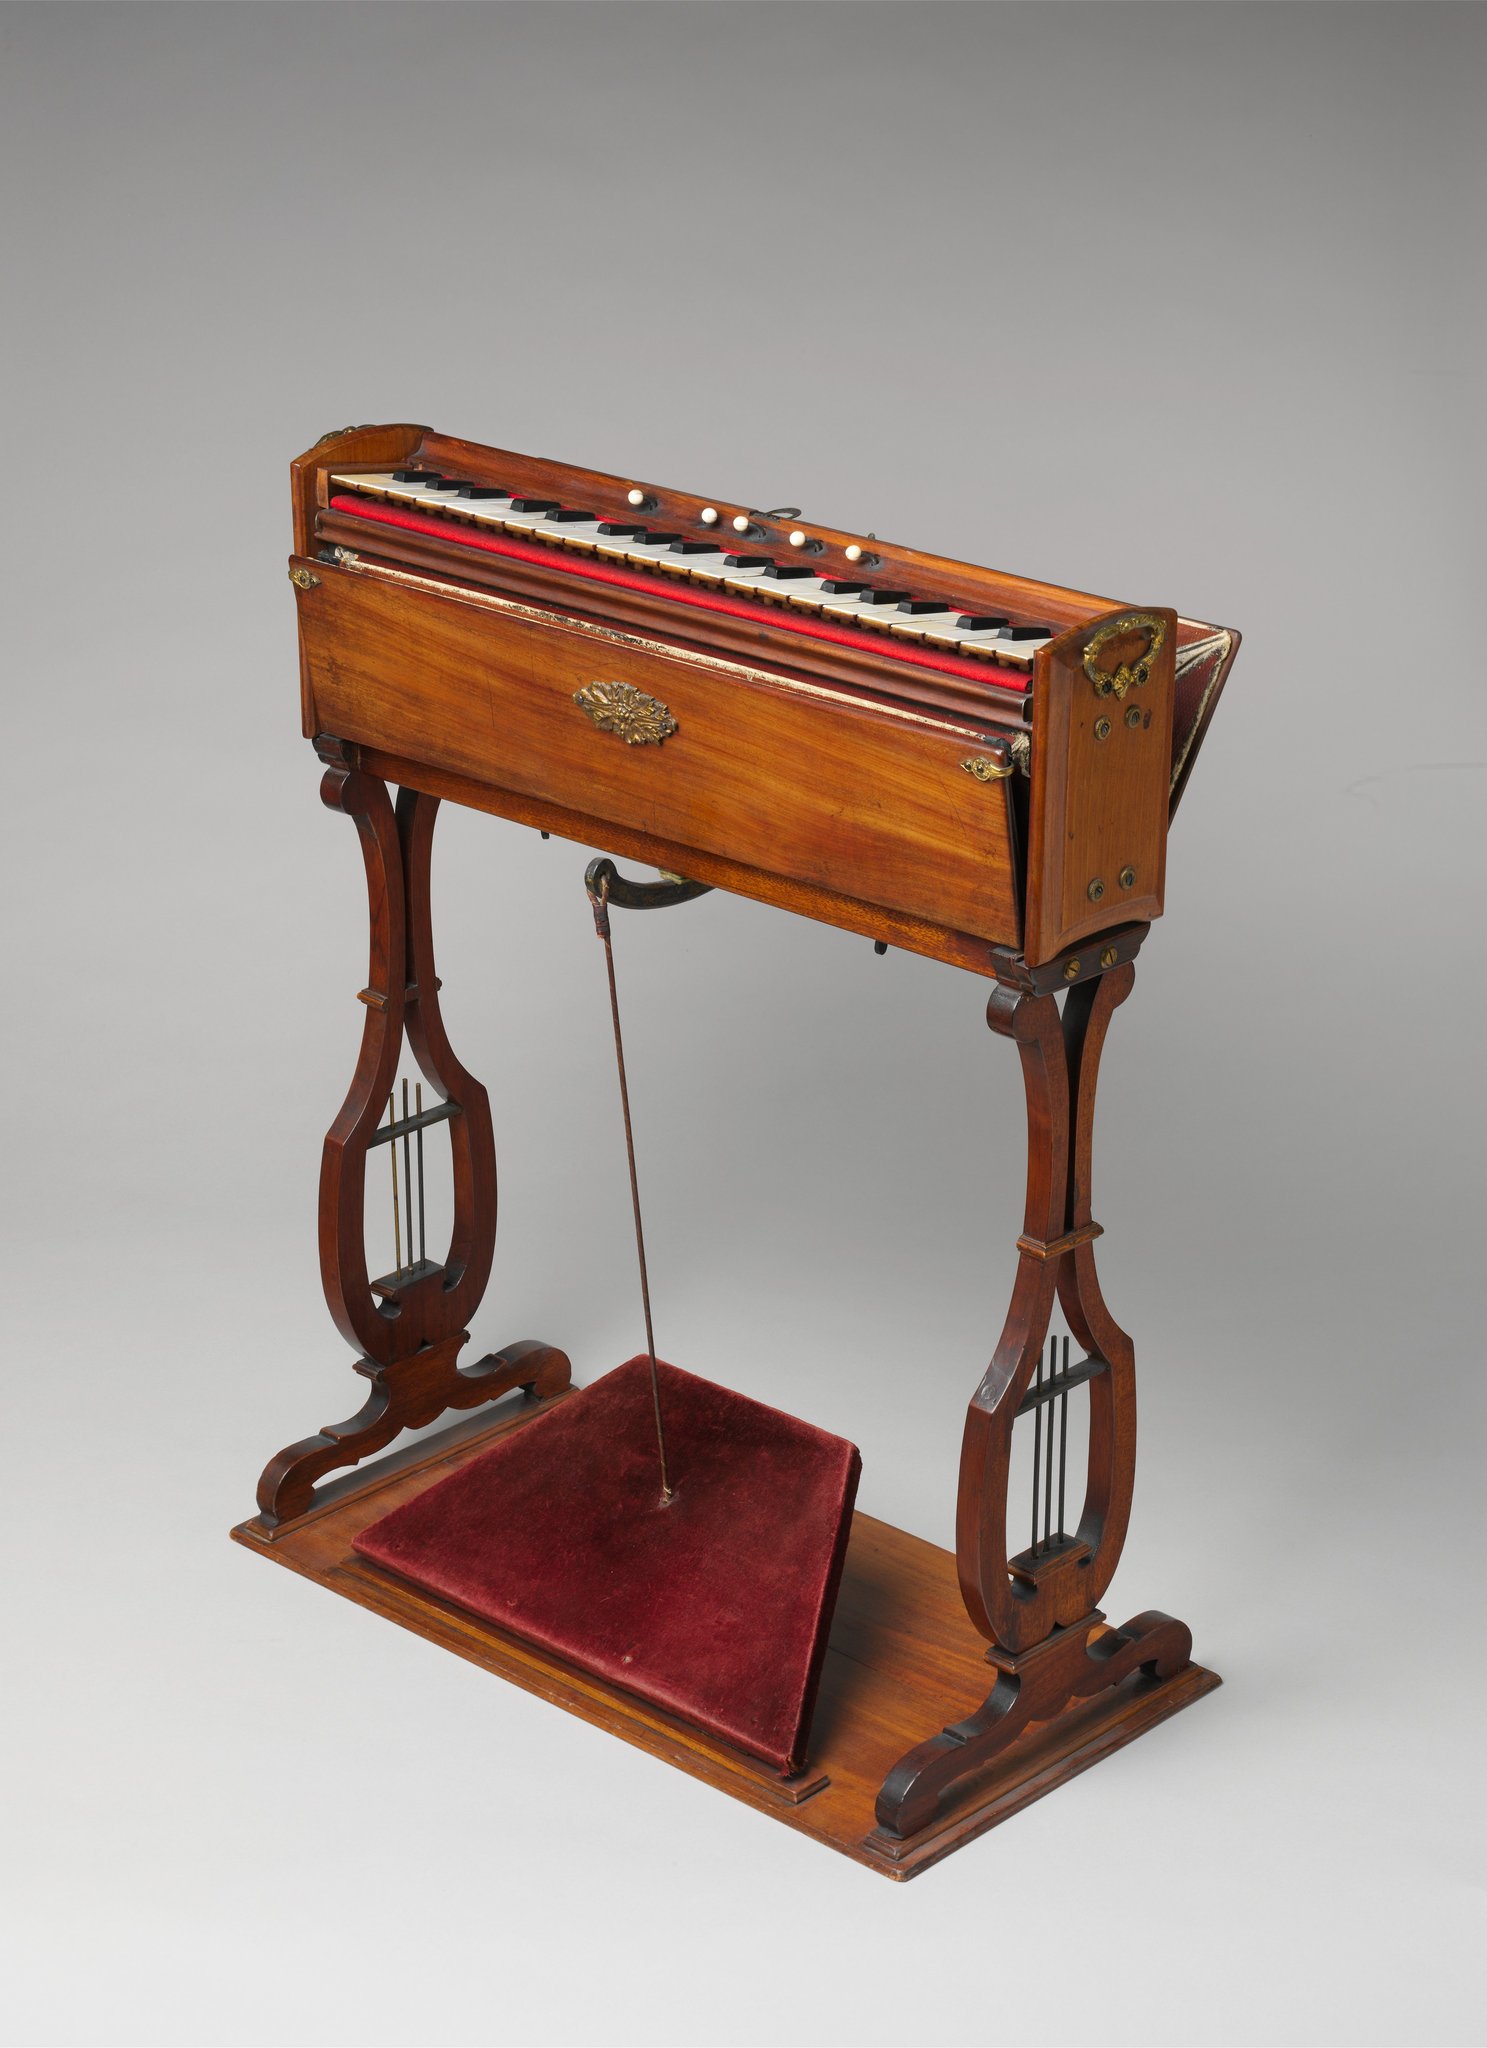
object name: reed organ physharmonika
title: Reed Organ (Physharmonica)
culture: french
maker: alexander-françois debain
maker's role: maker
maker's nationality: french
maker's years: 1809-1877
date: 1860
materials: brass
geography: france